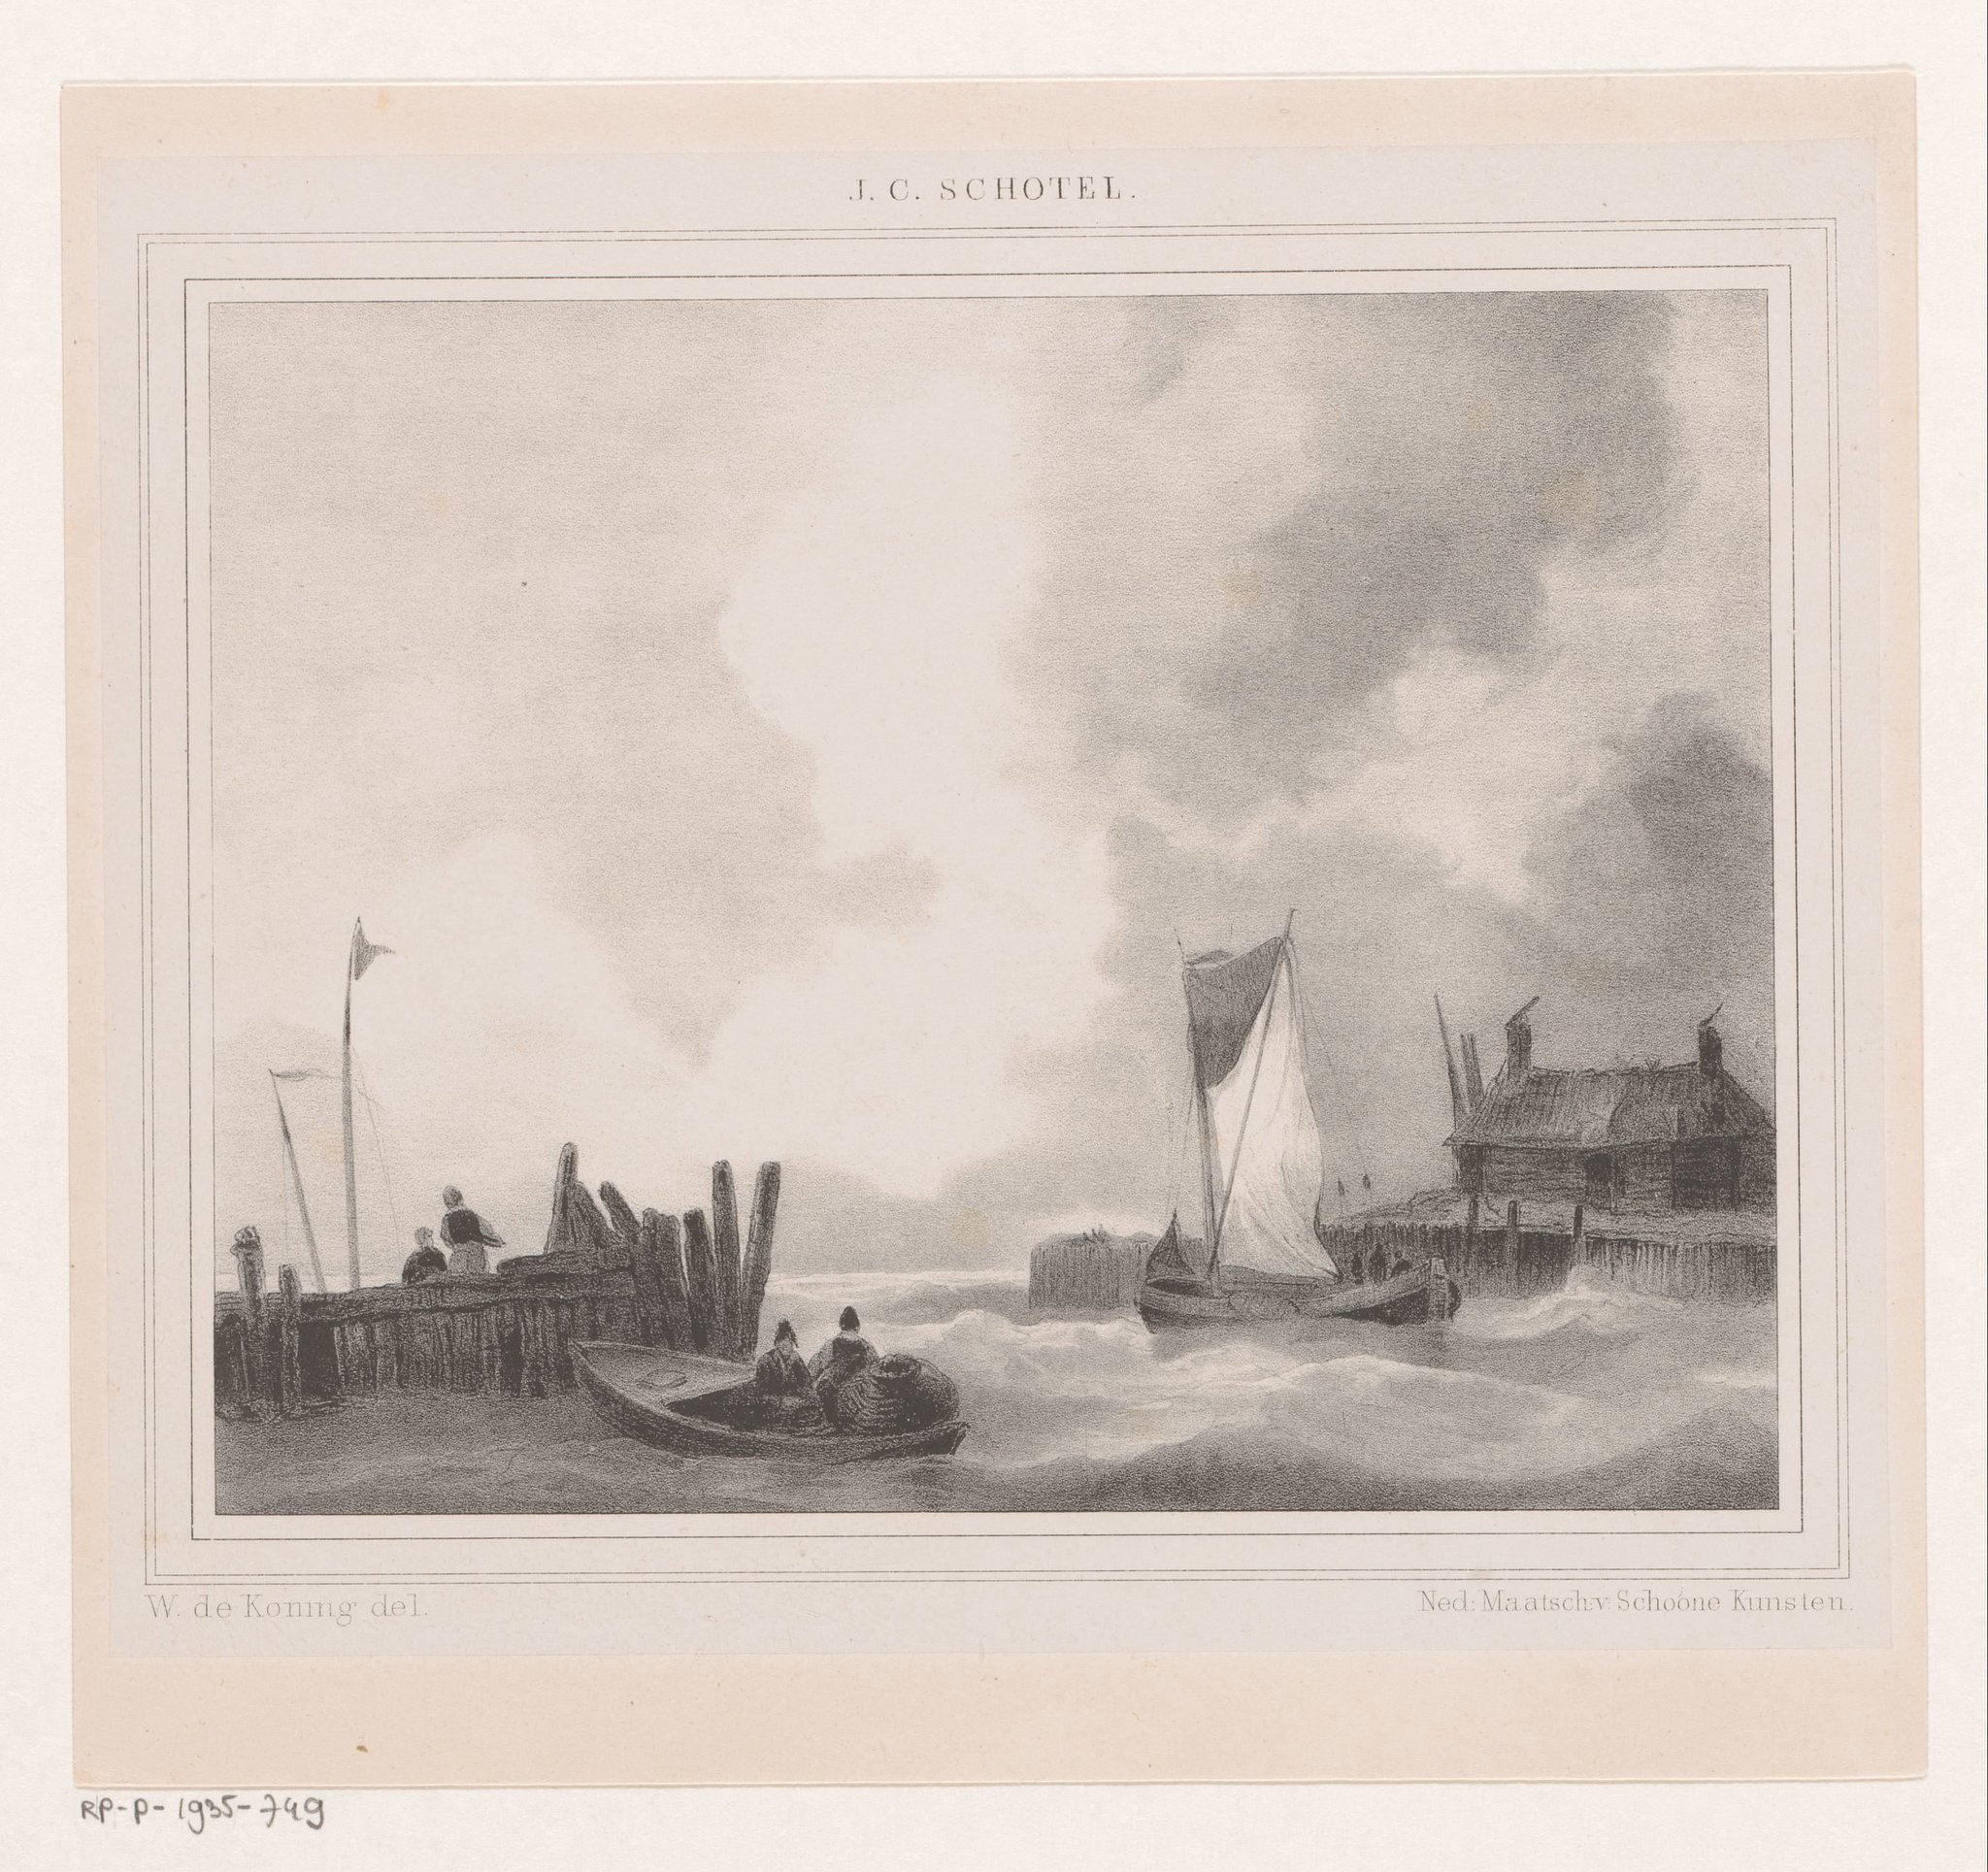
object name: print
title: Haven met boten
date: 1842-1843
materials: paper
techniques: lithograph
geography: the hague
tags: harbour, sailing-ship, sailing-boat, rowing-boat, canoe, etc.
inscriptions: collector's mark: Lugt 2228, collector's mark: Lugt 2760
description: In de haven op middelhoge golven deinen een roei- en een zeilboot. Links op de kade staan twee figuren, daarachter twee masten. Rechts een houten huis.